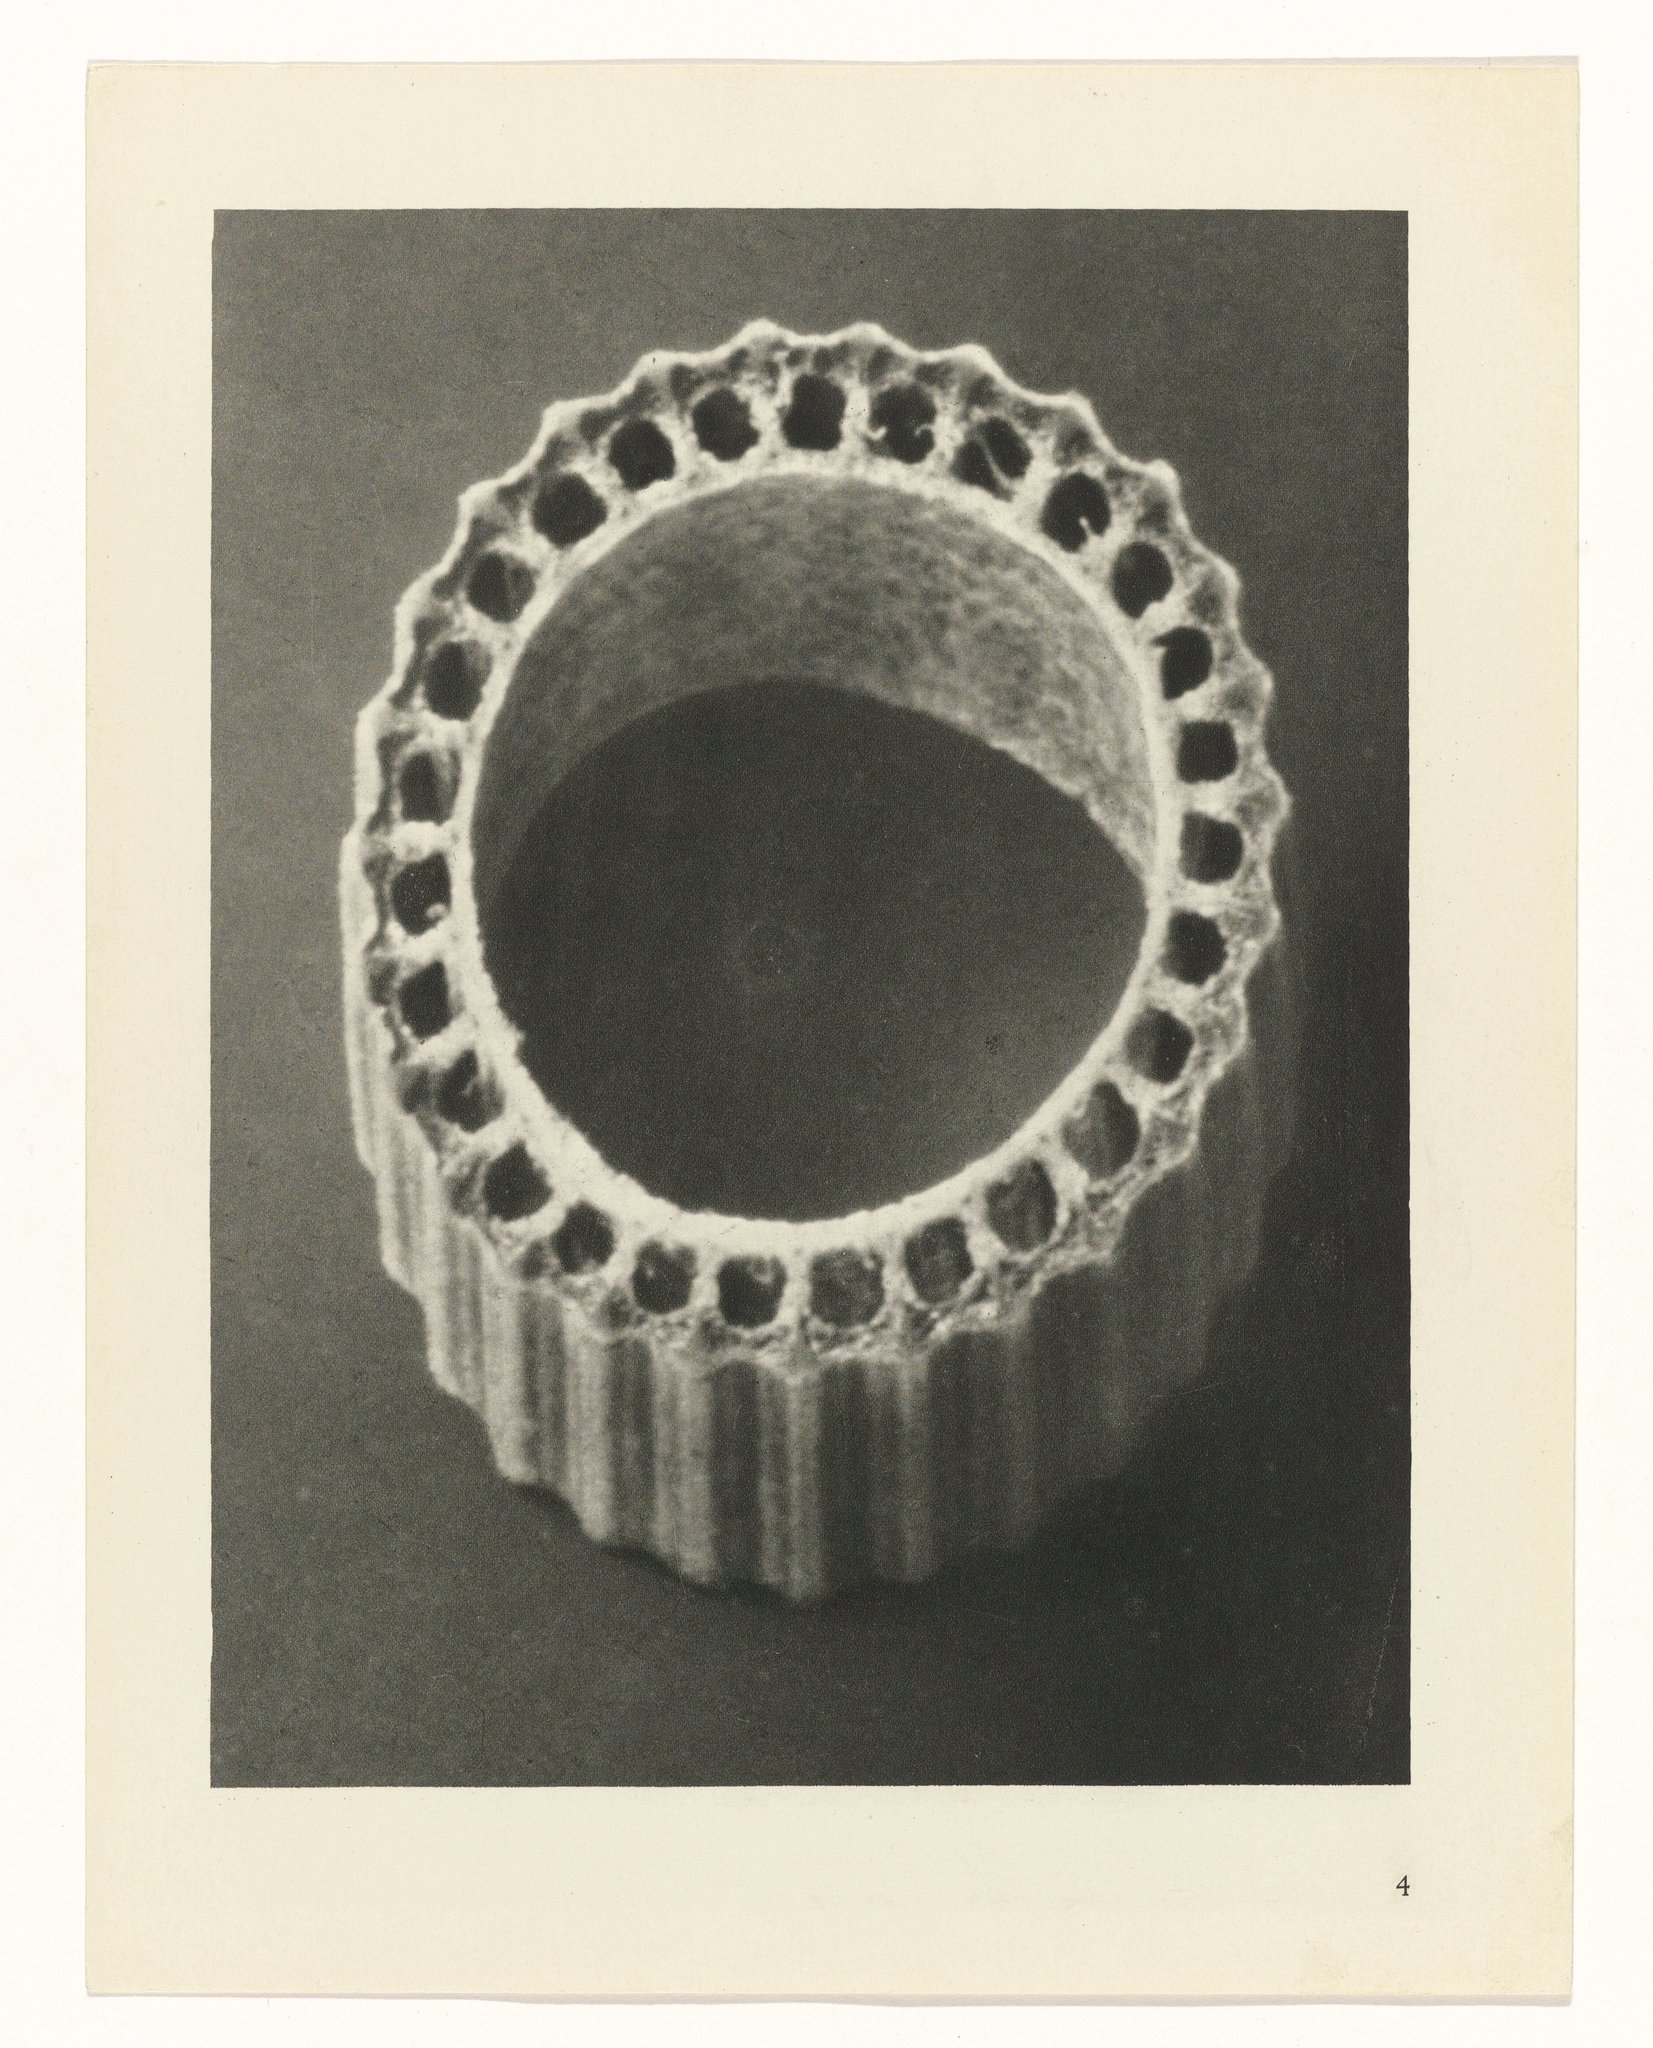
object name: photograph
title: Urformen der Kunst: photographische Pflanzenbilder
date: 1928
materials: ink, paper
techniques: rotogravure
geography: berlin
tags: plants (in general)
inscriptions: number: ‘4’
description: facher Vergrößerung. Afkomstig uit losbladige uitgave.